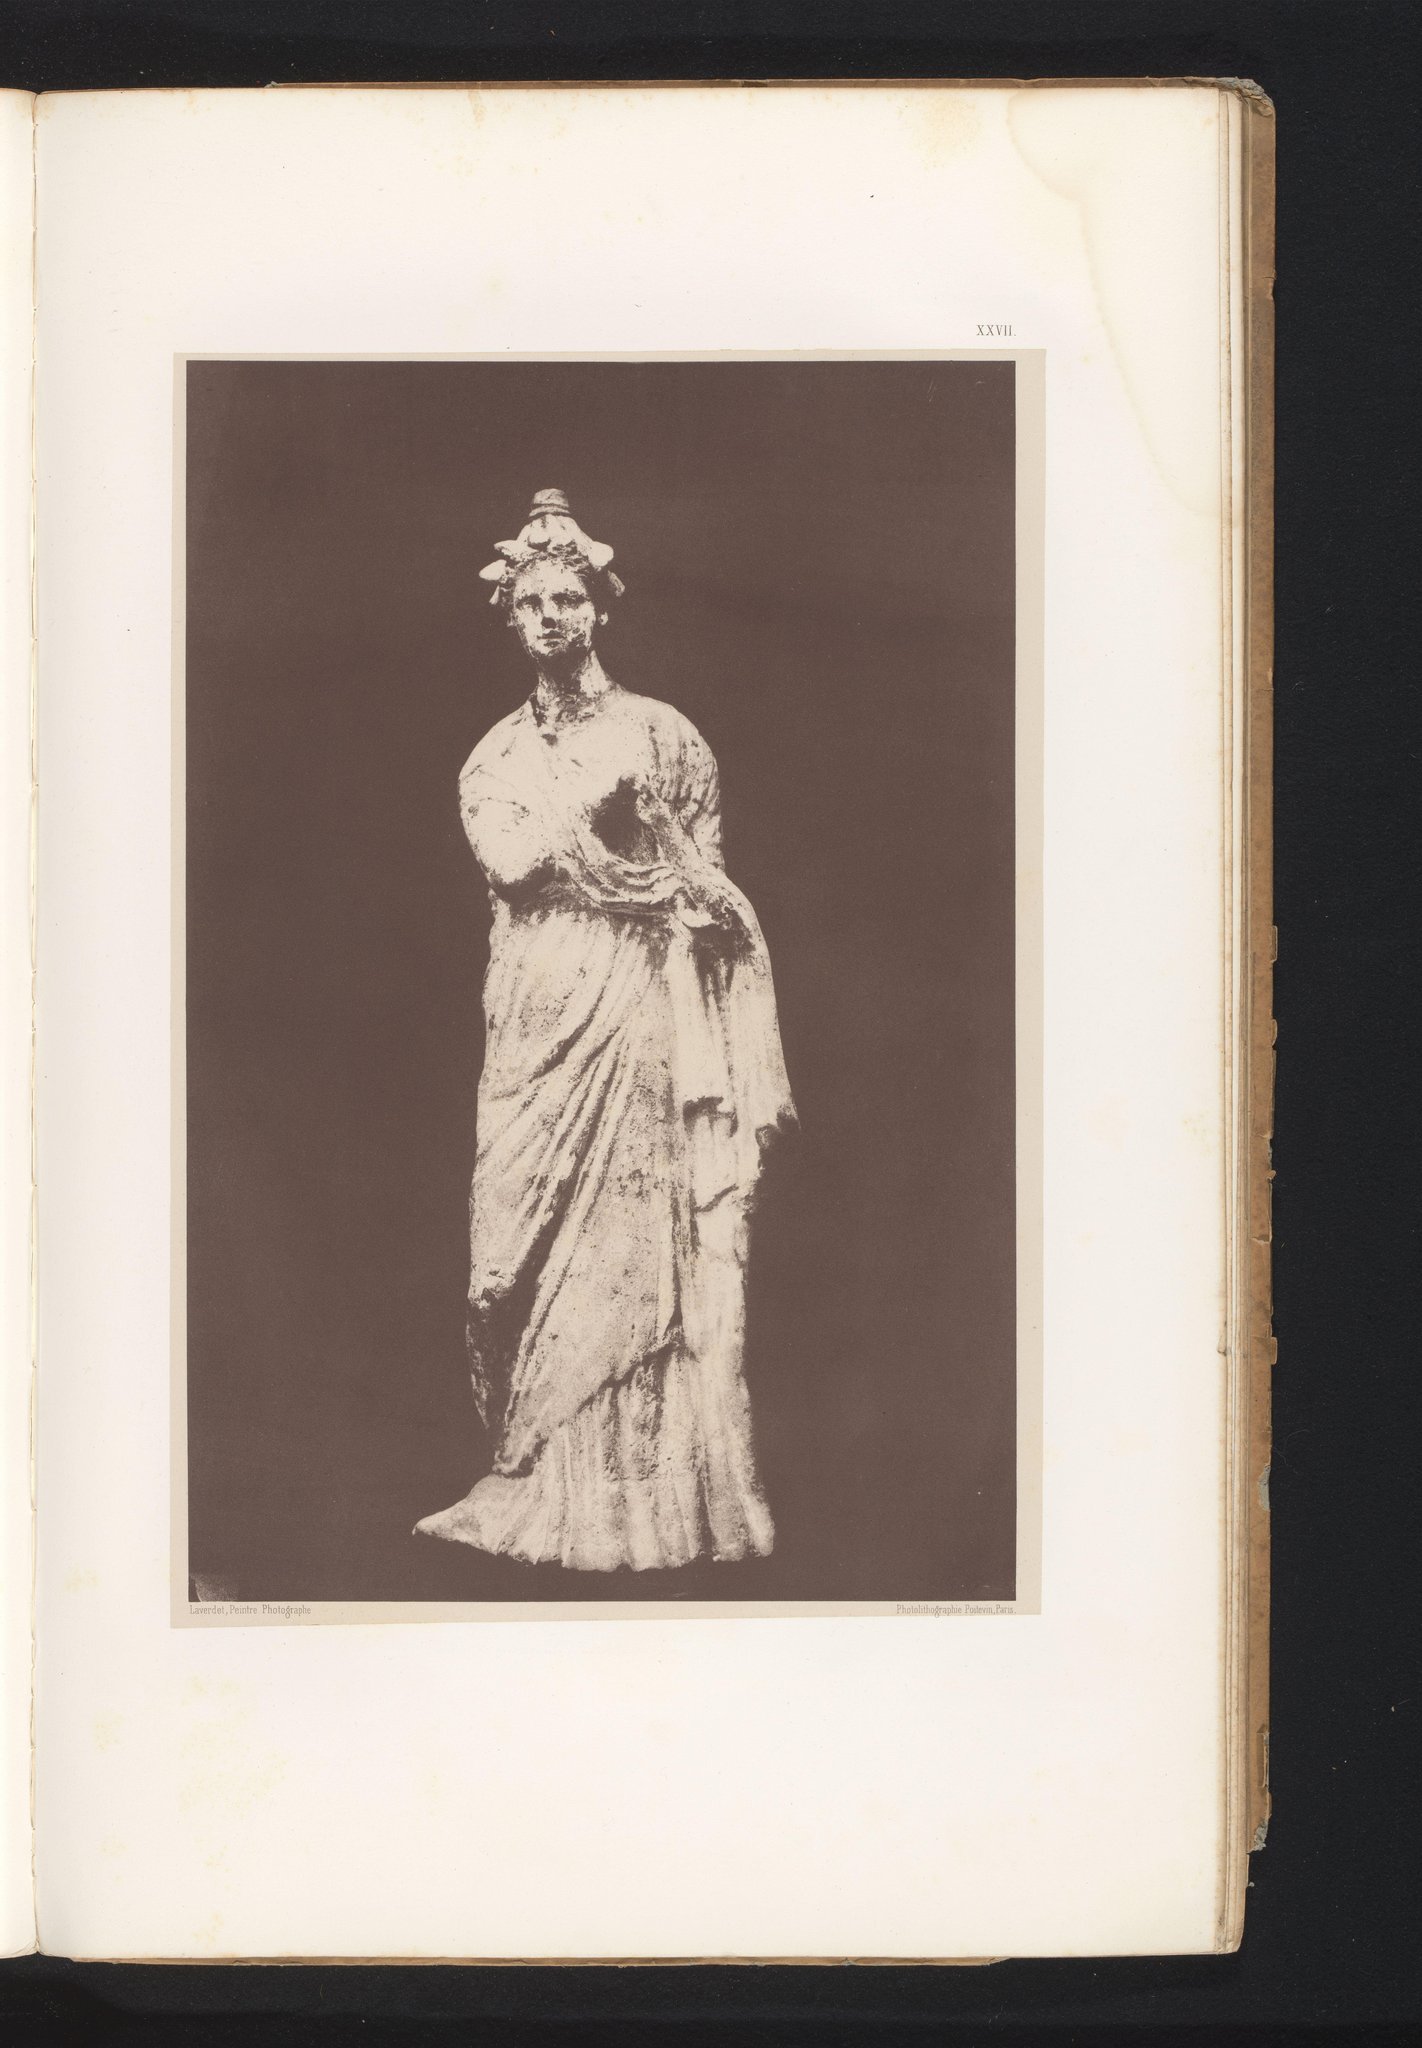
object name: page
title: Terracotta sculptuur van een vrouw met een bloemenkrans op haar hoofd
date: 1852-1857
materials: paper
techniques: photolithography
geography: paris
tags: adult woman, garland, wreath, piece of sculpture, reproduction of a piece of sculpture (+ clay, sand, etc. ~ arts)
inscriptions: number: ‘XXVII.’